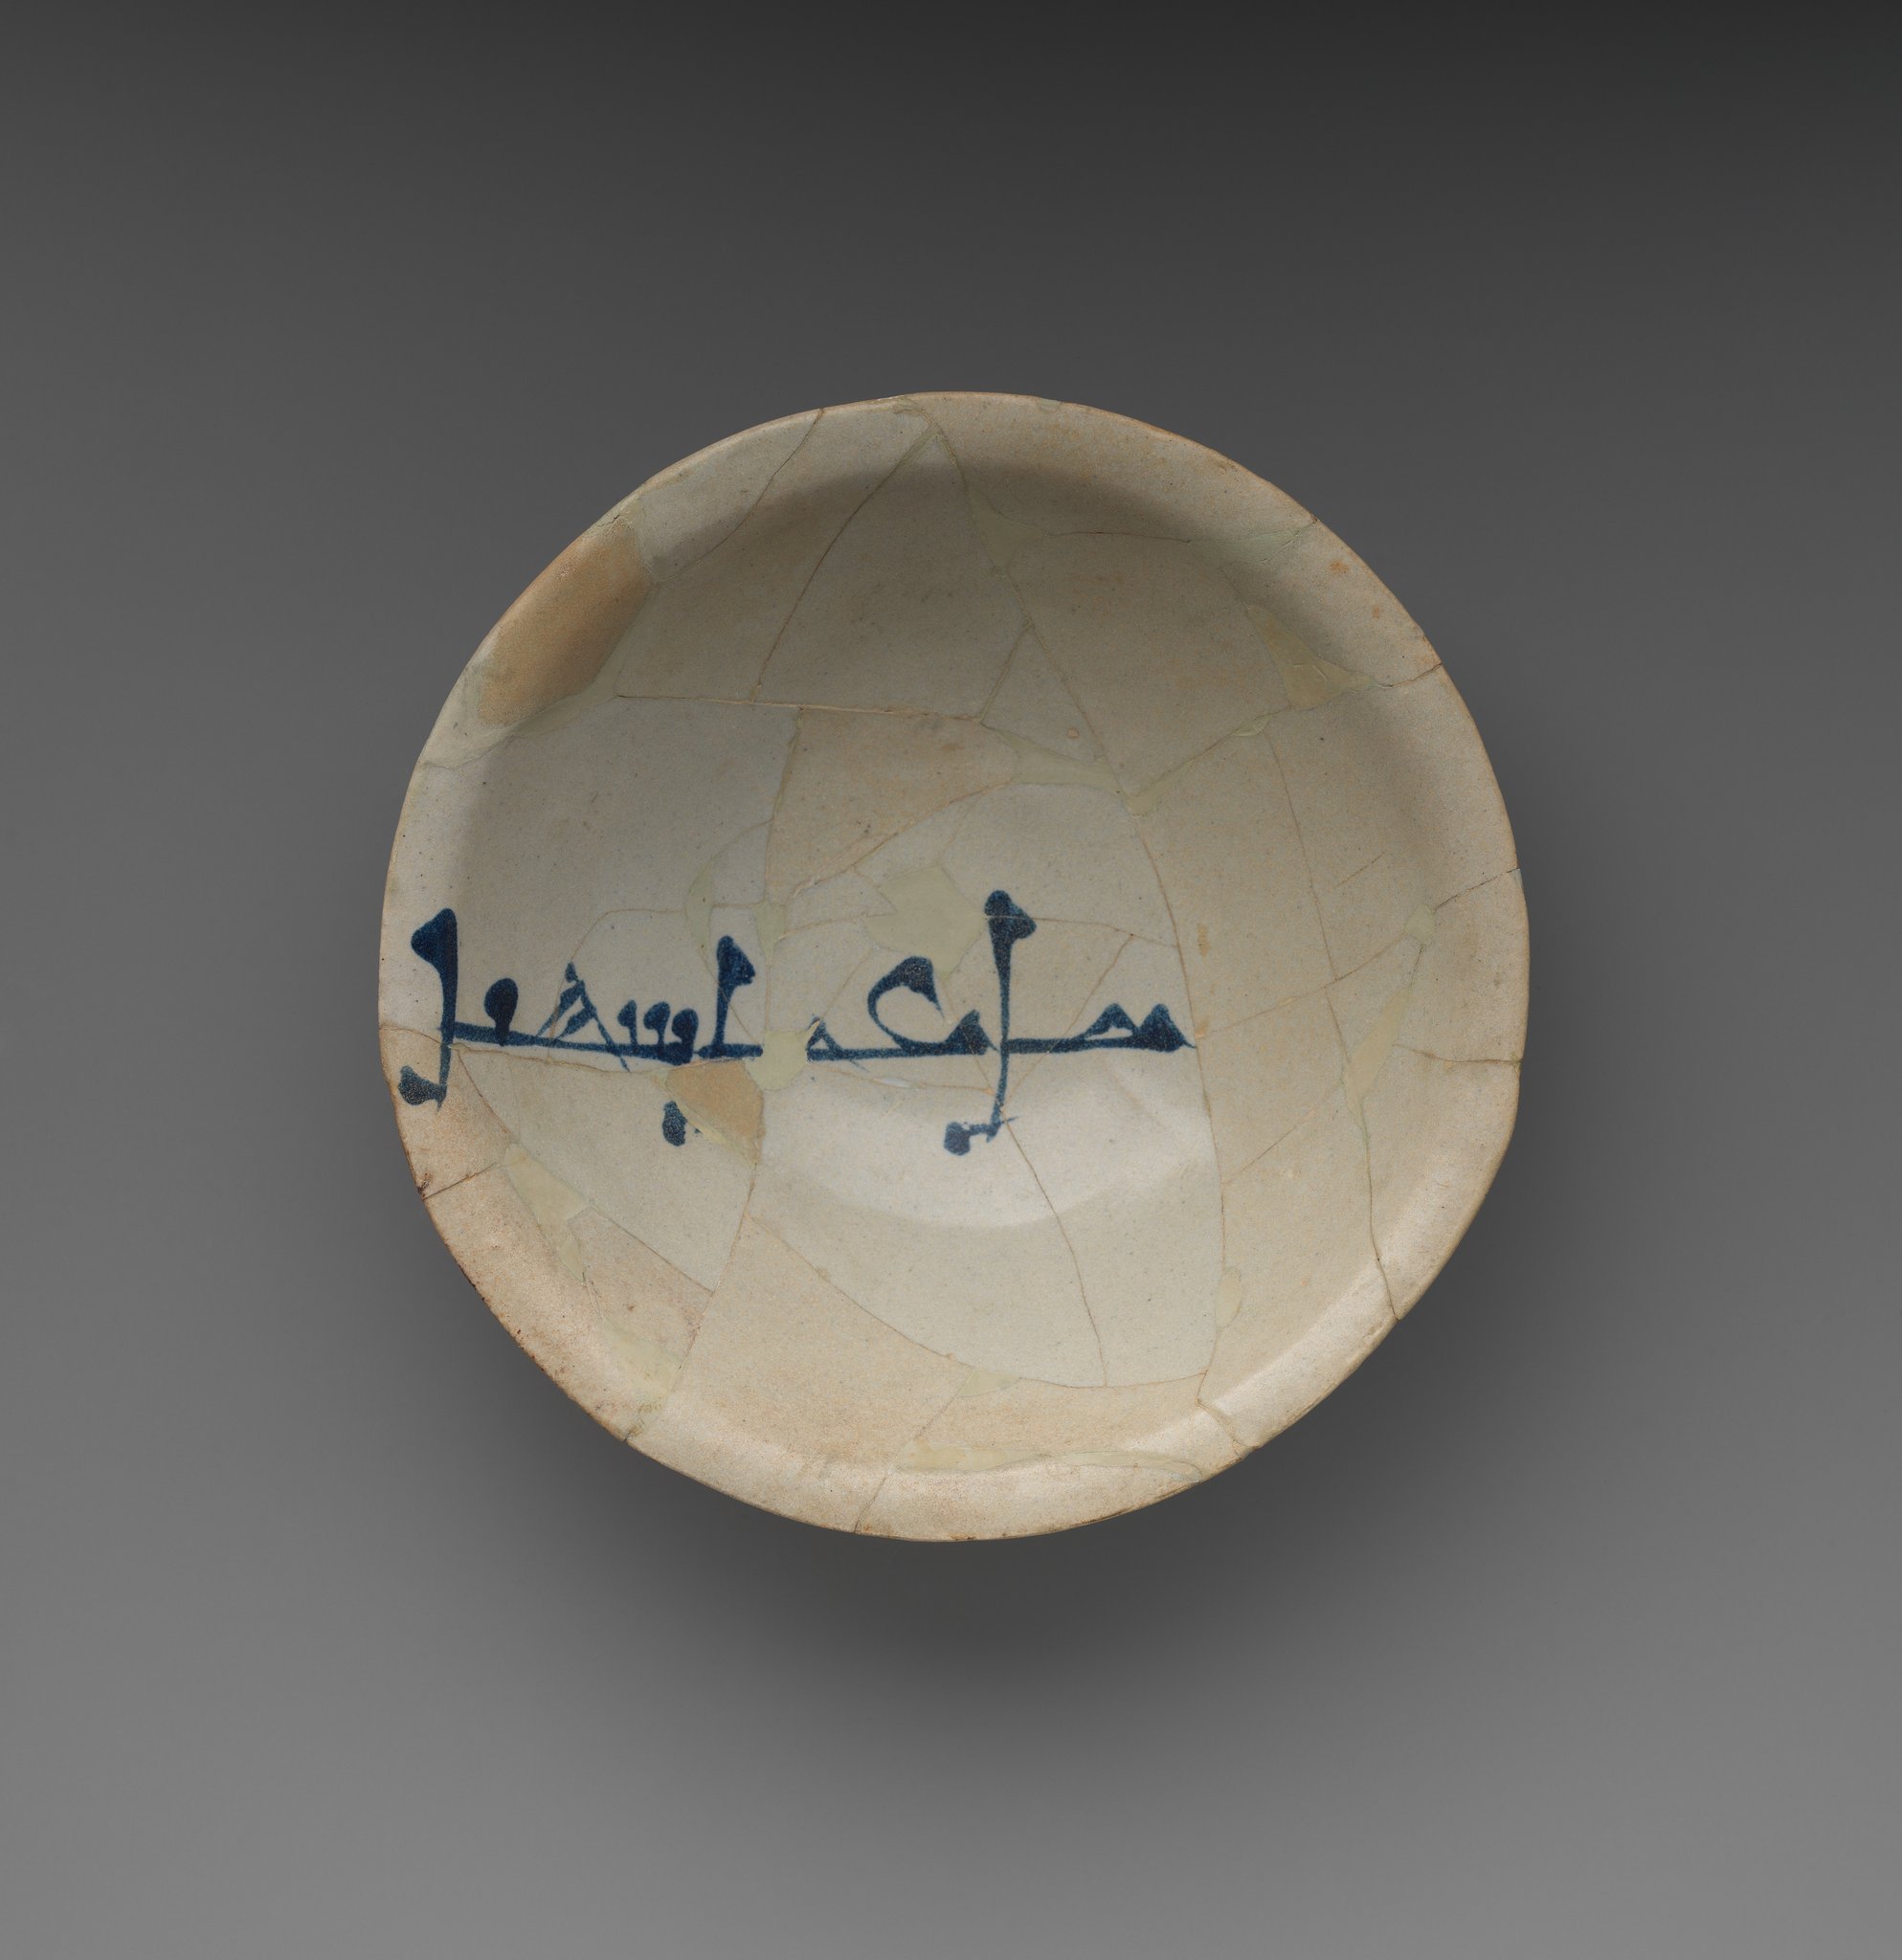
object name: bowl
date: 801-900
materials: earthenware, glaze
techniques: painting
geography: iraq